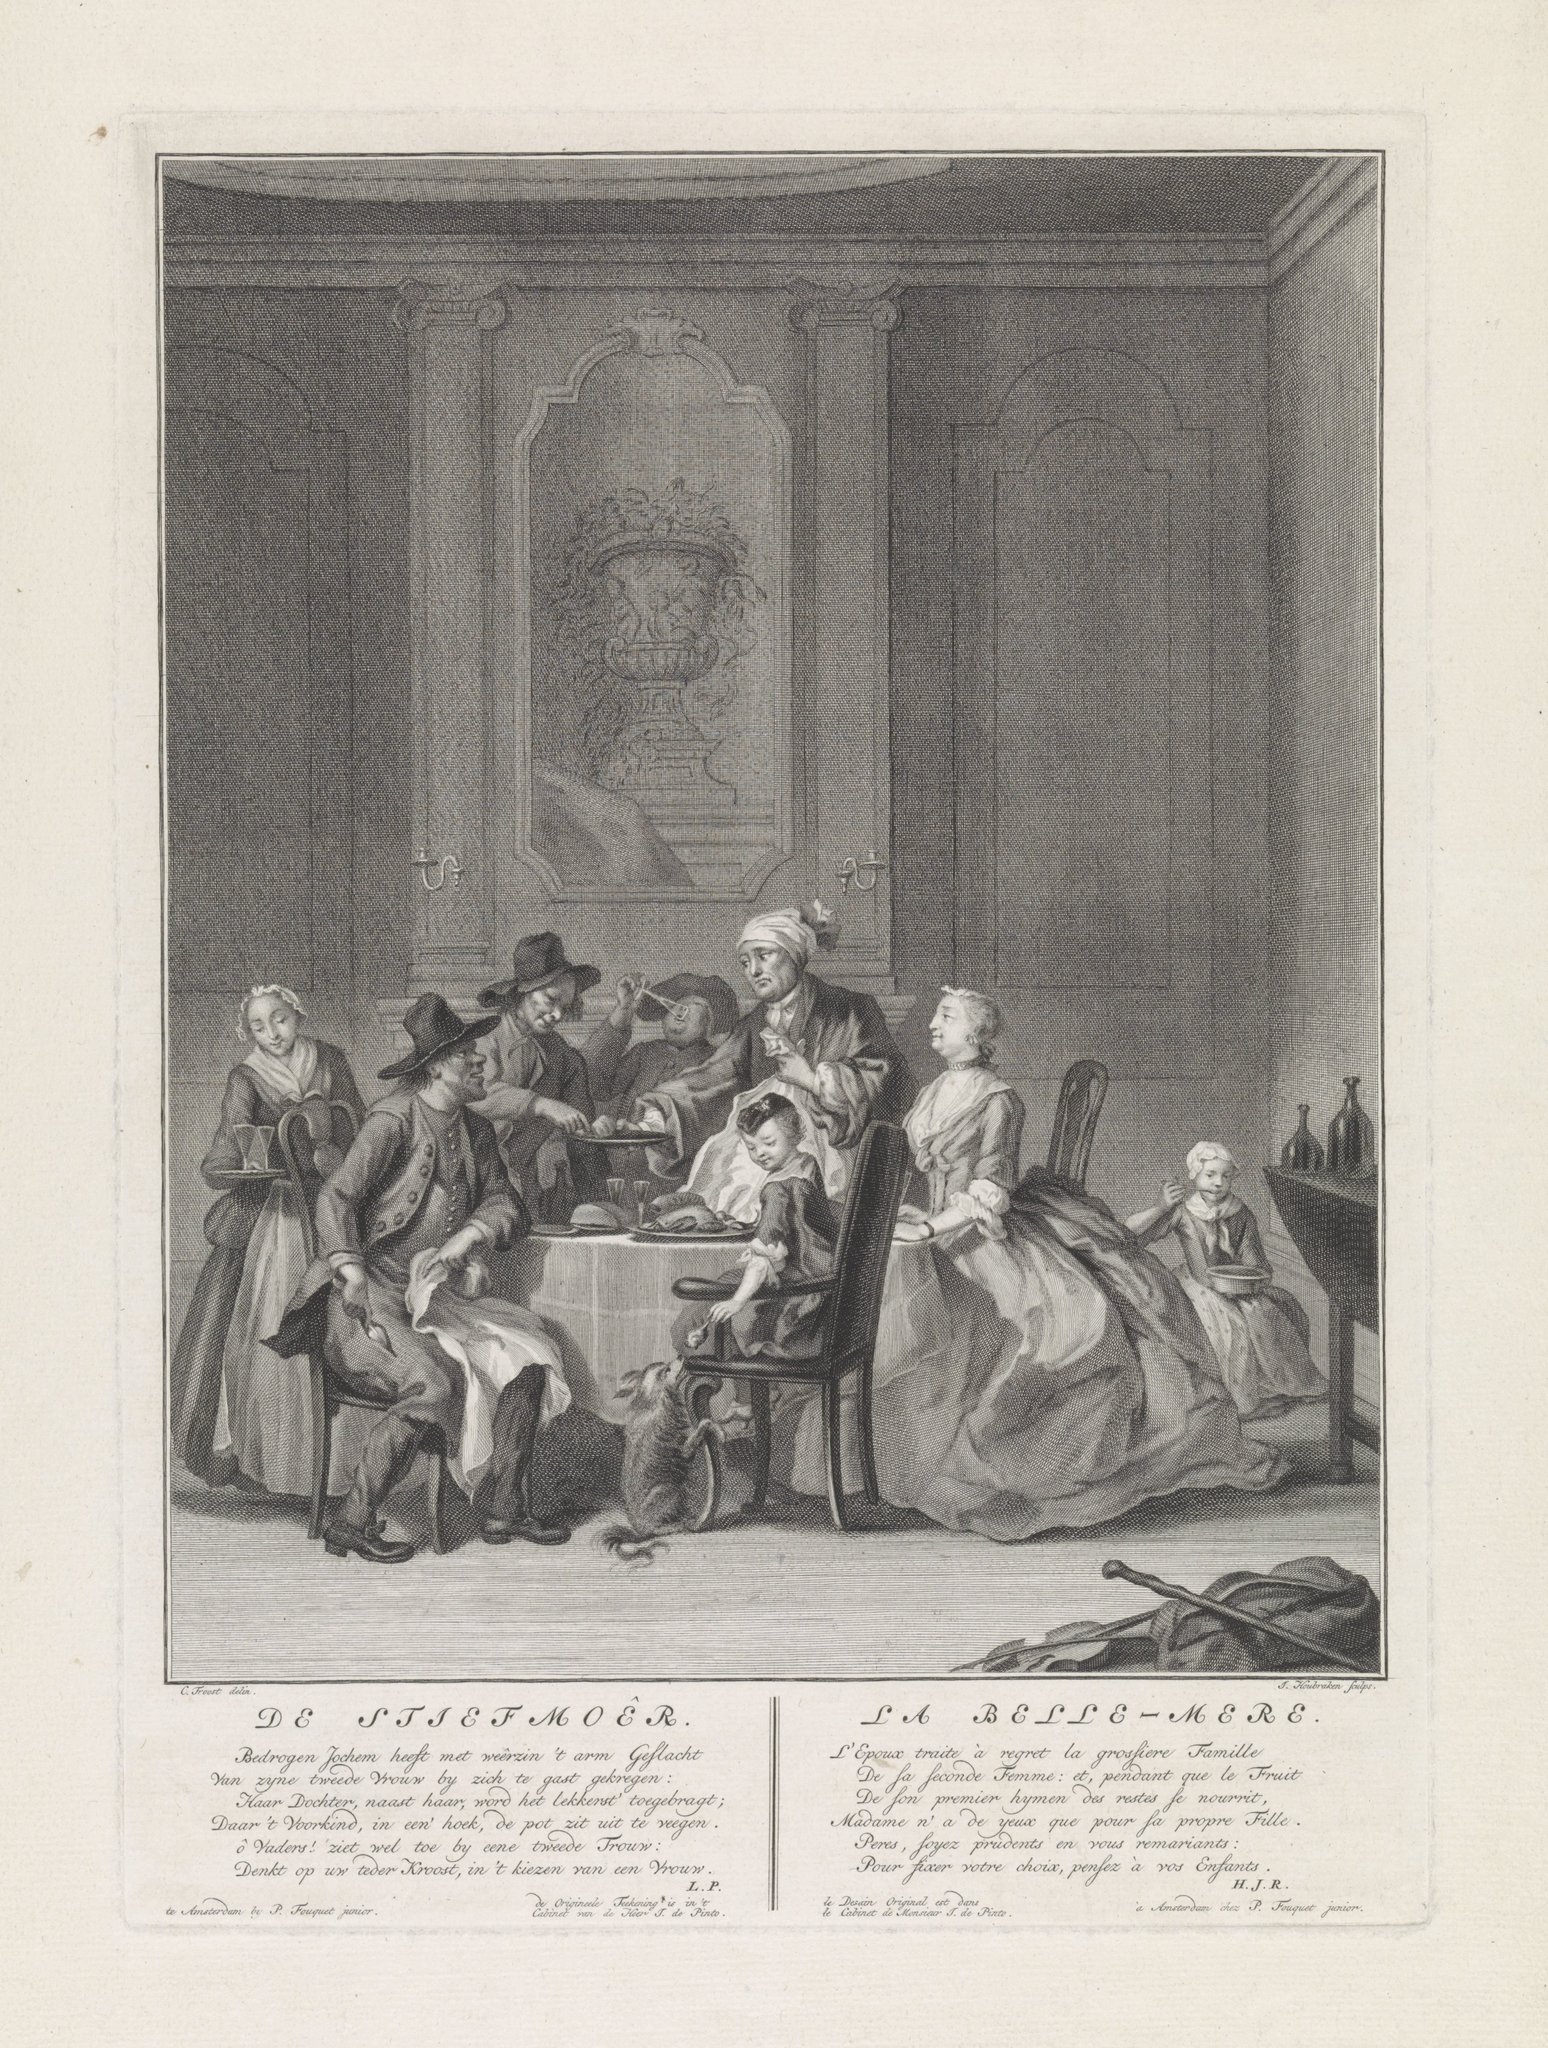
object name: print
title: De stiefmoer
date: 1760-1780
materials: paper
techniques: engraving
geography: amsterdam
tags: giving food, eating and drinking, dining-room, comedy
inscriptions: collector's mark: Lugt 2233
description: Een eetkamer met figuren rond een tafel. Rechts een rijk aangeklede vrouw en kind. Tegenover hen drie sober geklede heren. Een man bedient hen. Rechts op de achtergrond een kind dat uit een pan eet. Links een bediende met glazen. Scène uit het blijspel De Stiefmoêr van Thomas Asselyn uit 1684, waarin het personage Jochem de arme familie van zijn tweede vrouw op bezoek krijgt. Zijn eigen kind moet de pot uitlikken, terwijl zijn tweede vrouw en haar familie het lekkerste eten krijgen.